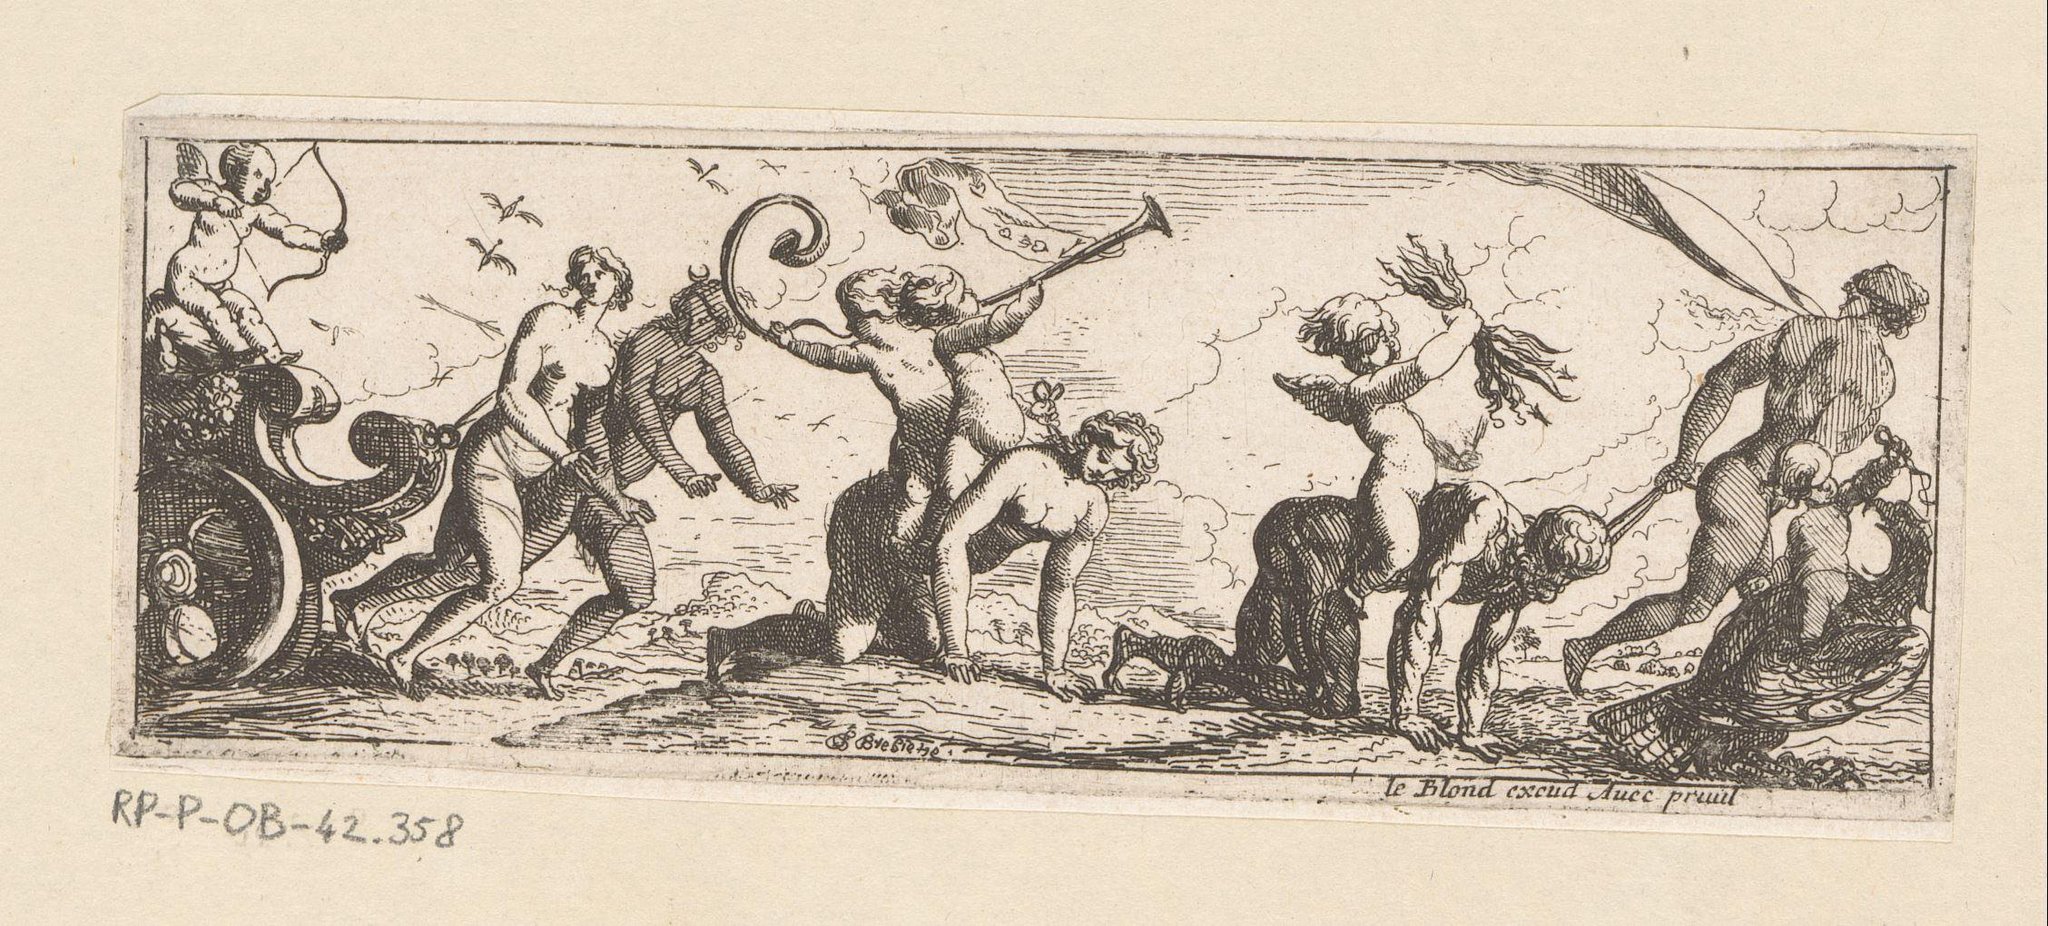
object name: print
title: Processie met putti en geketende goden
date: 1608-1650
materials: paper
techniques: etching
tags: (story of) diana (artemis), (story of) jupiter (zeus), (story of) venus (aphrodite), cupids: 'amores', 'amoretti', 'putti', procession ~ non-christian religions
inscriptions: collector's mark: Lugt 240